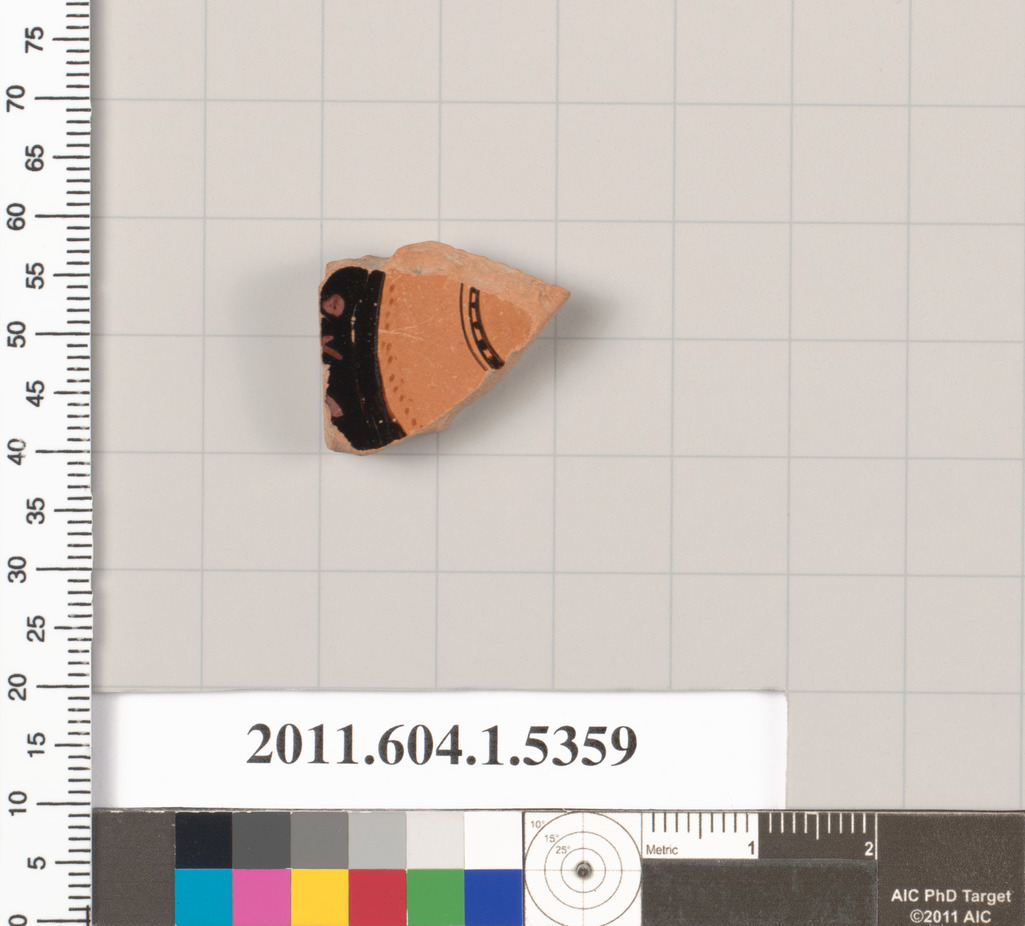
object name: kylix fragment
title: Terracotta fragment of a kylix (drinking cup)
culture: greek, attic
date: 520-500 BCE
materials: terracotta